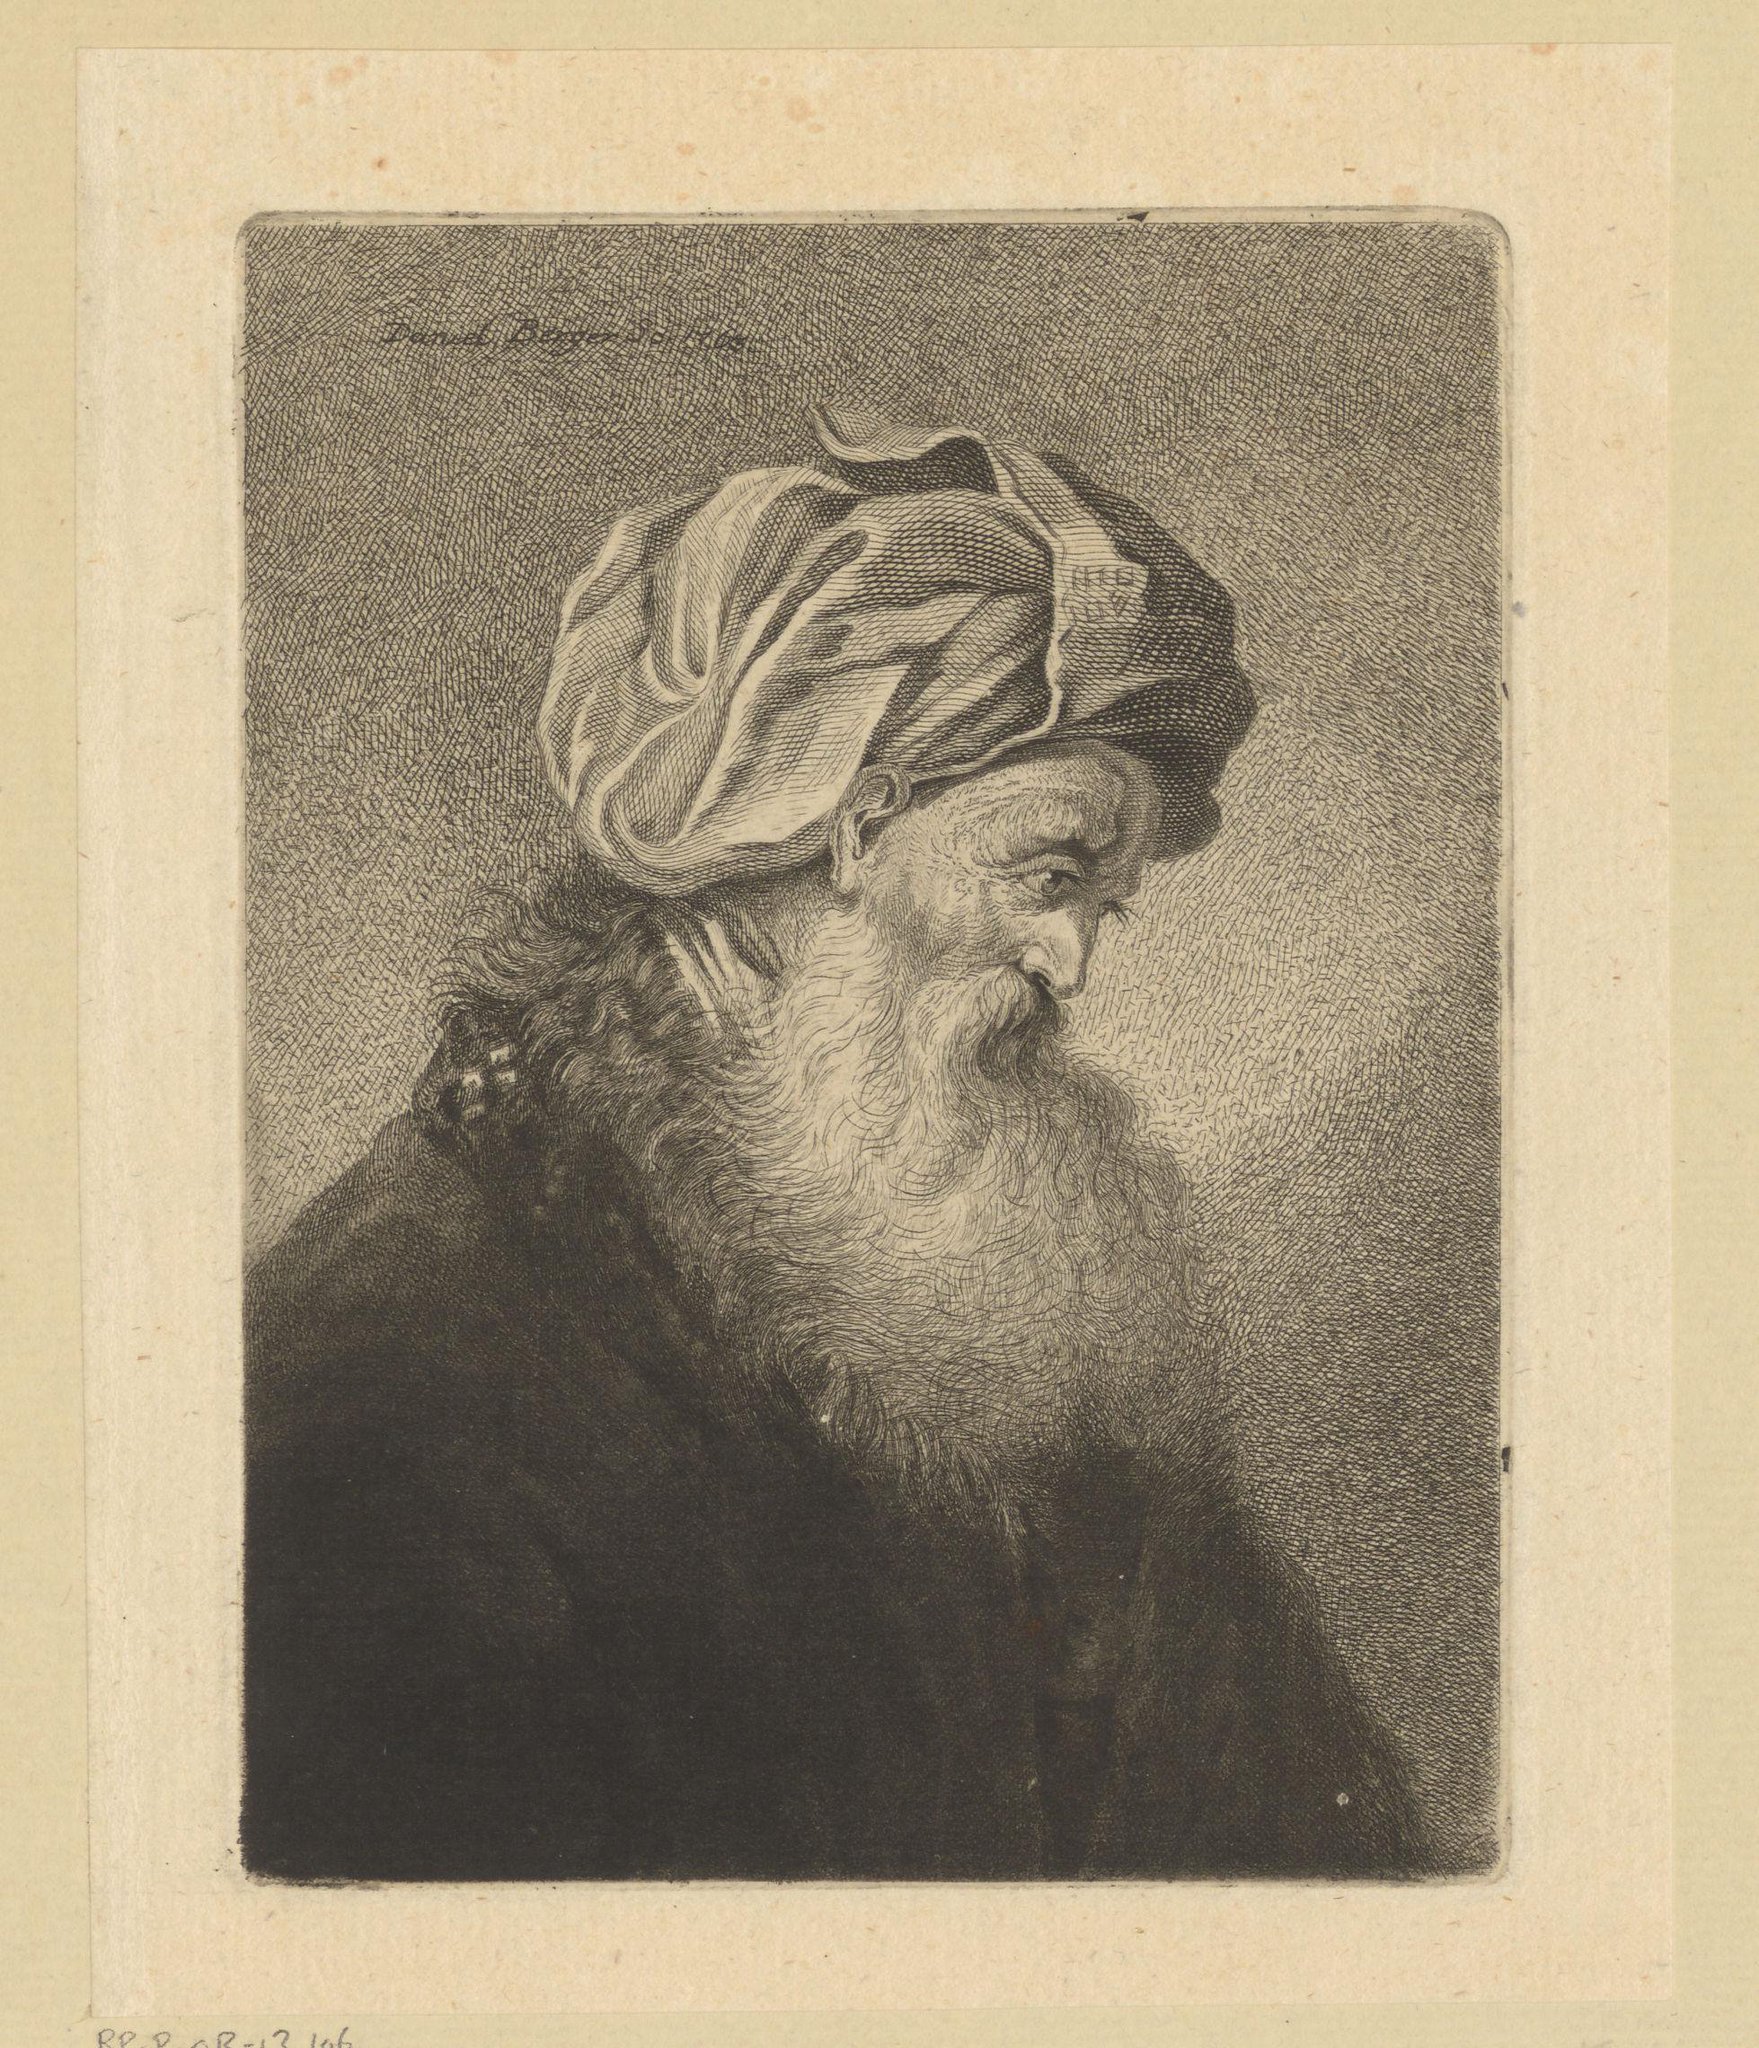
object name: print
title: Buste van een oude Joodse man met baard en tulband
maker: daniel berger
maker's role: print maker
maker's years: 1744-1824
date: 1763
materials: paper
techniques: etching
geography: berlin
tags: old man, head-gear: turban, beard, the jews, jewish life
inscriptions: collector's mark: Lugt 2228